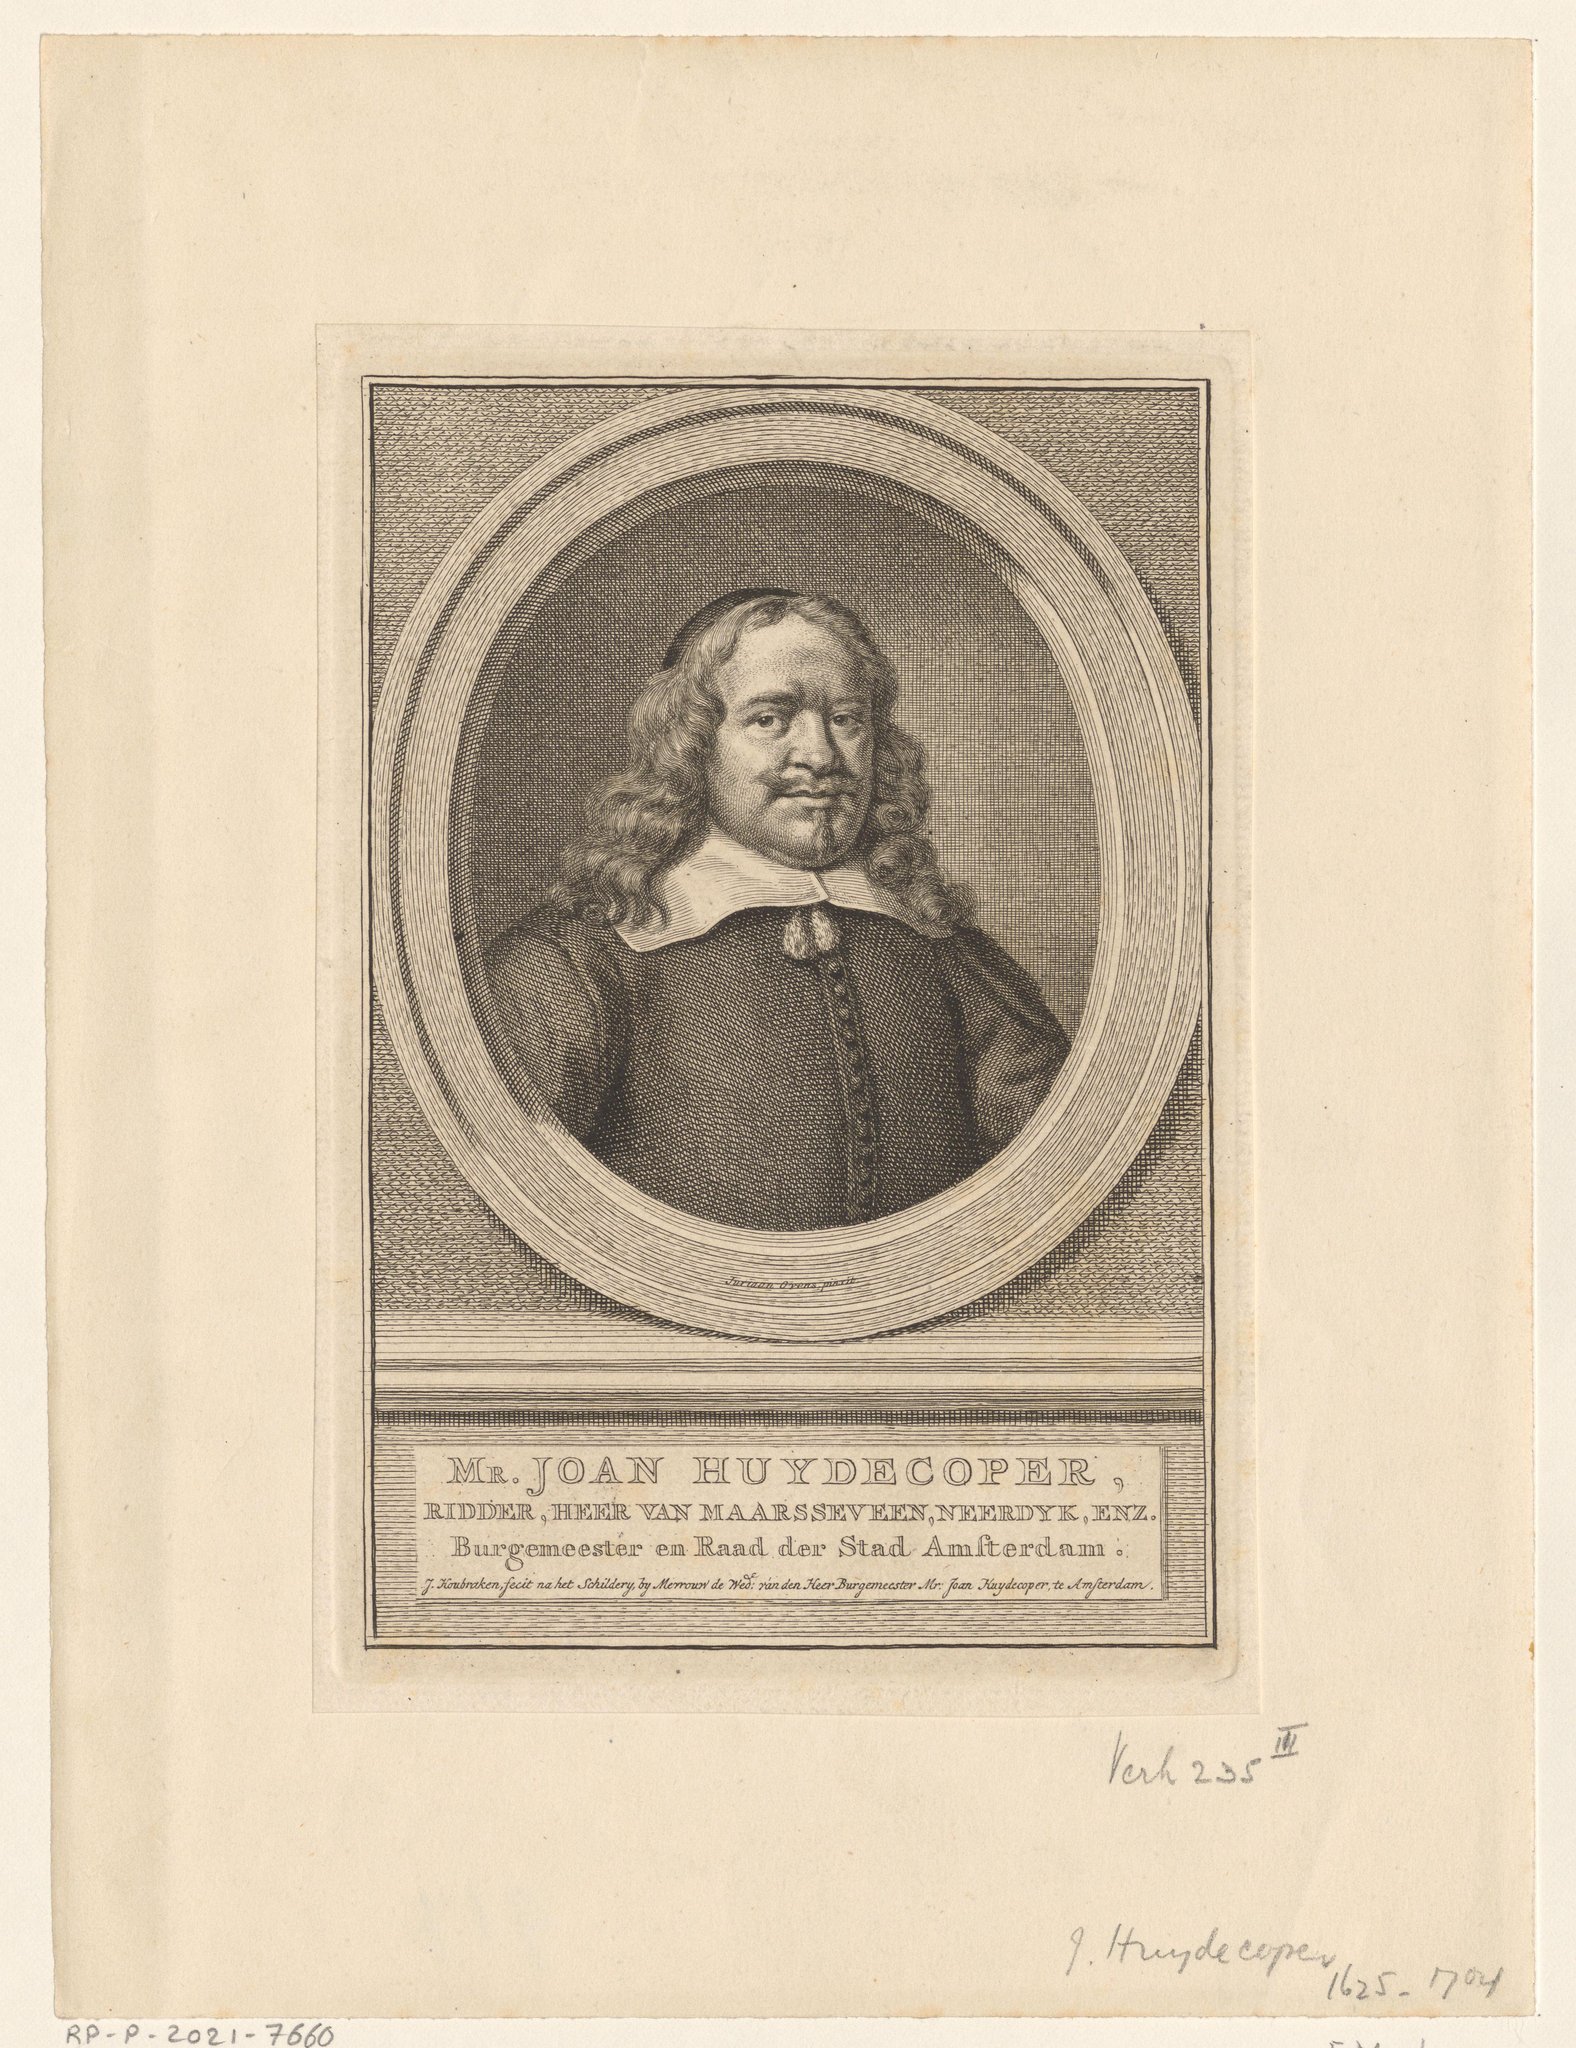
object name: print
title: Portret van Joan Huydecoper van Maarsseveen II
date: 1749-1759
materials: paper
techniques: engraving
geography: amsterdam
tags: joan huydecoper van maarsseveen (ii), mayor, burgomaster, historical persons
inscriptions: collector's mark: Lugt 2228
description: Prent oorspronkelijk bedoeld als aanvulling op: Wagenaar, Jan. Vaderlandsche historie, vervattende de geschiedenissen der Vereenigde Nederlanden (…). 21 dln. Amsterdam: Isaak Tirion, 1749-1759 (eerste editie). De portretten werden echter pas toegevoegd bij de 1796-editie door Johannes Allart: Wagenaar, Jan. Vaderlandsche historie, vervattende de geschiedenissen der nu Vereenigde Nederlanden (…). 21 dln. Amsterdam: Johannes Allart, 1790-1796. Prent ook gebruikt in: Wagenaar, Jan. Amsterdam in zijne opkomst, aanwas, geschiedenissen, (...). Amsterdam: Isaak Tirion, 1760.